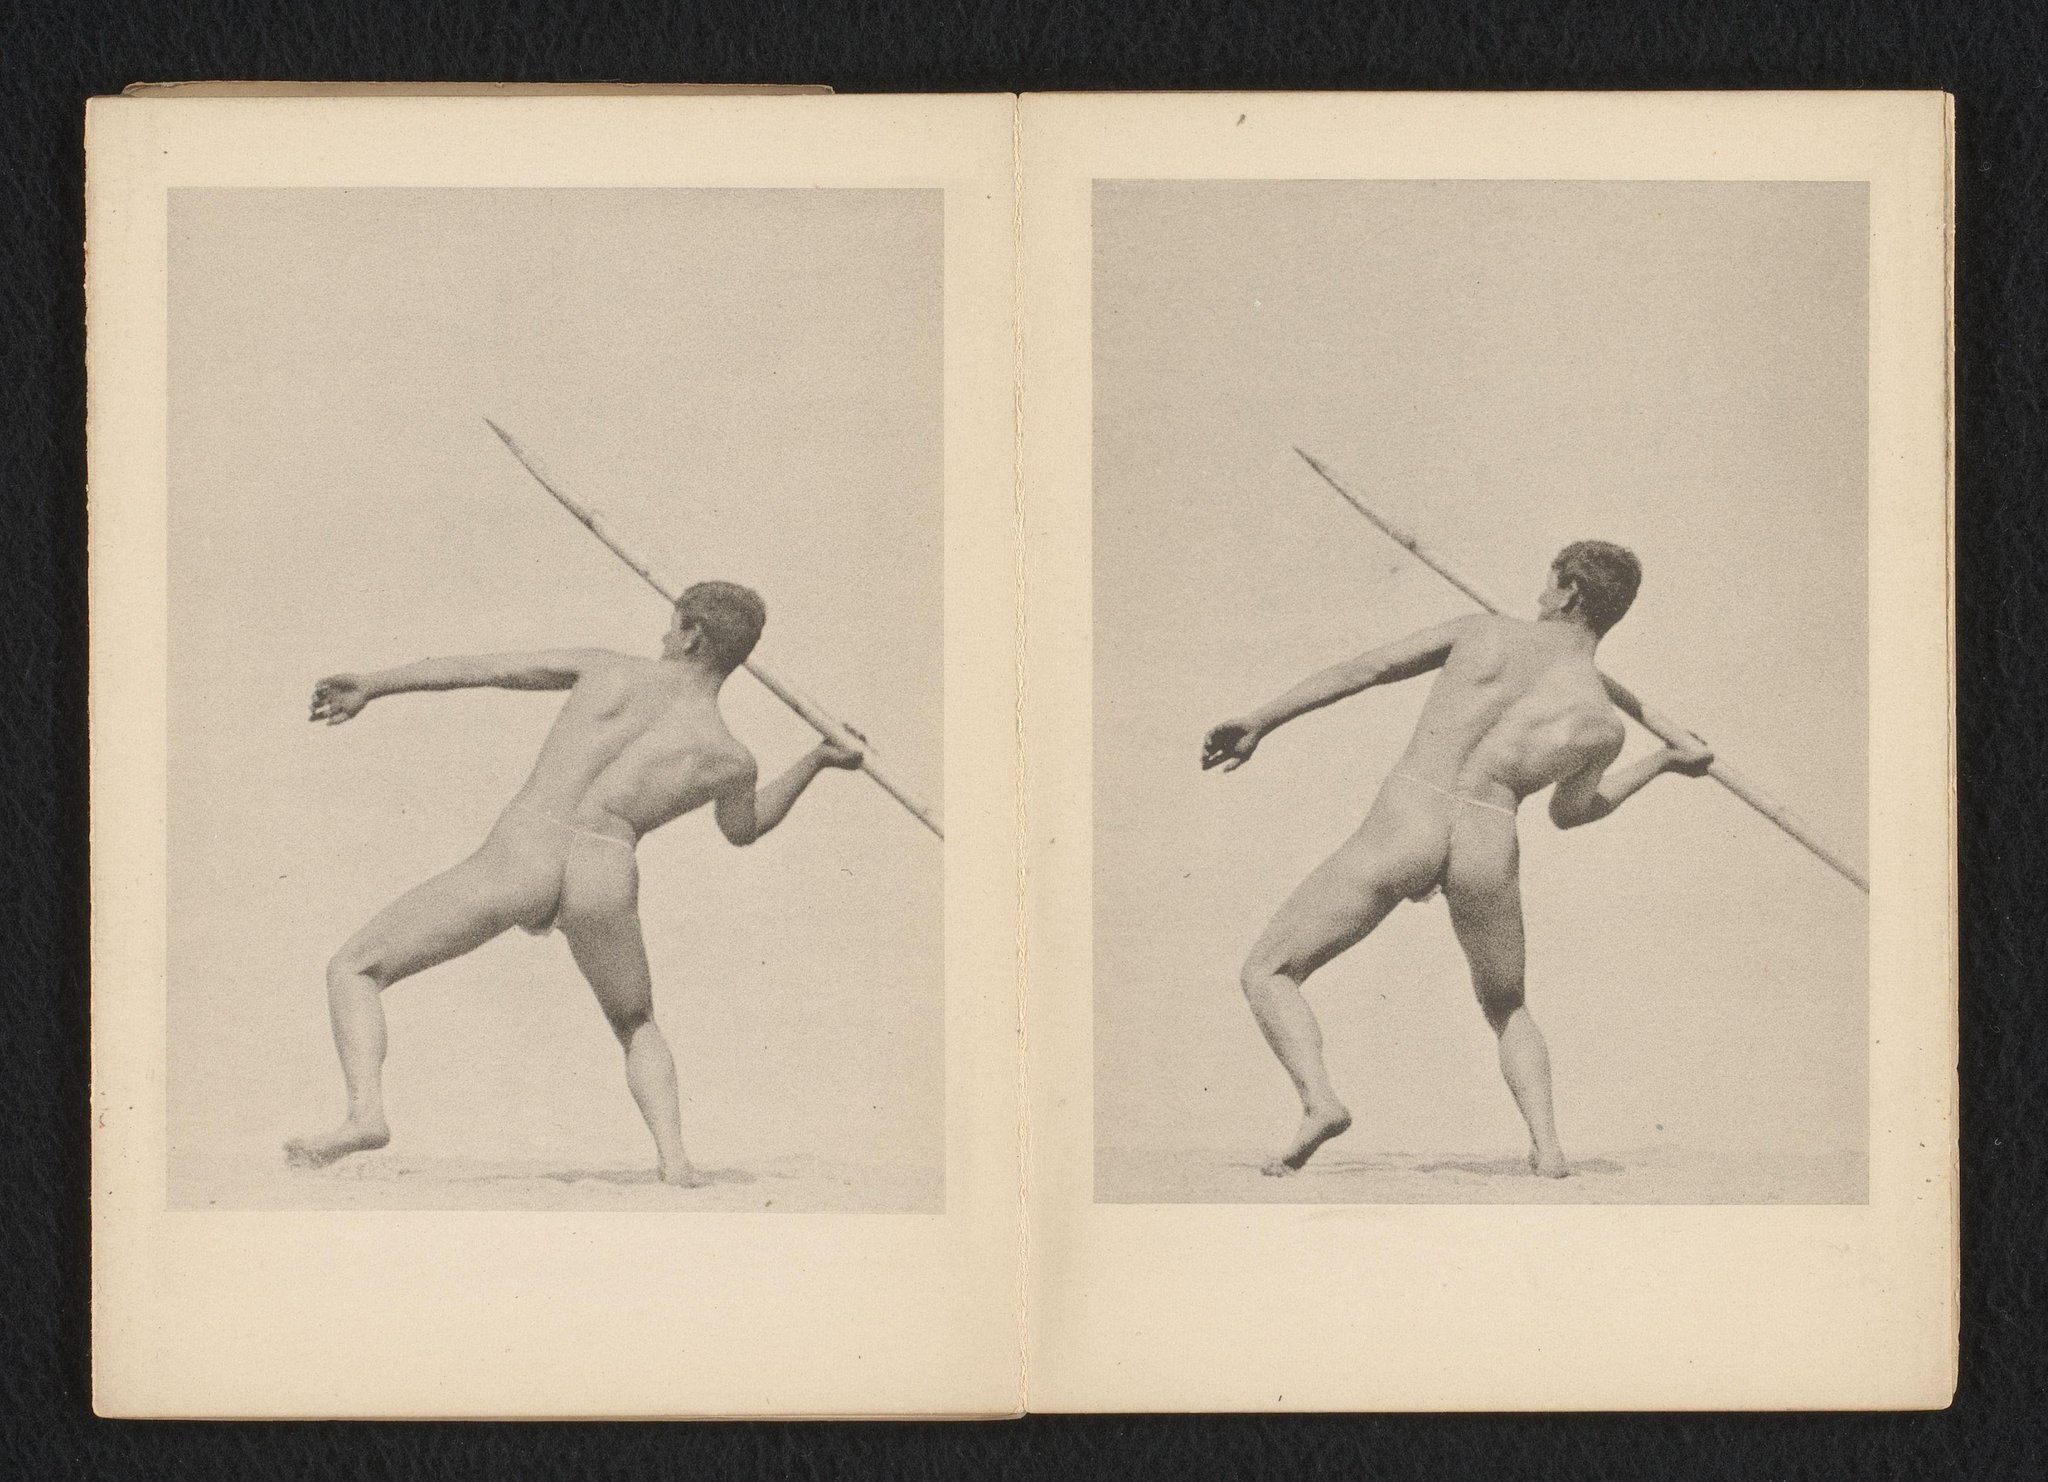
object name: photomechanical print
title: Man werpt een speer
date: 1886-1887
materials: paper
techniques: photograph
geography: lisse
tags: casting weapons: spear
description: Onderdeel van een sequentie van twaalf opnamen.